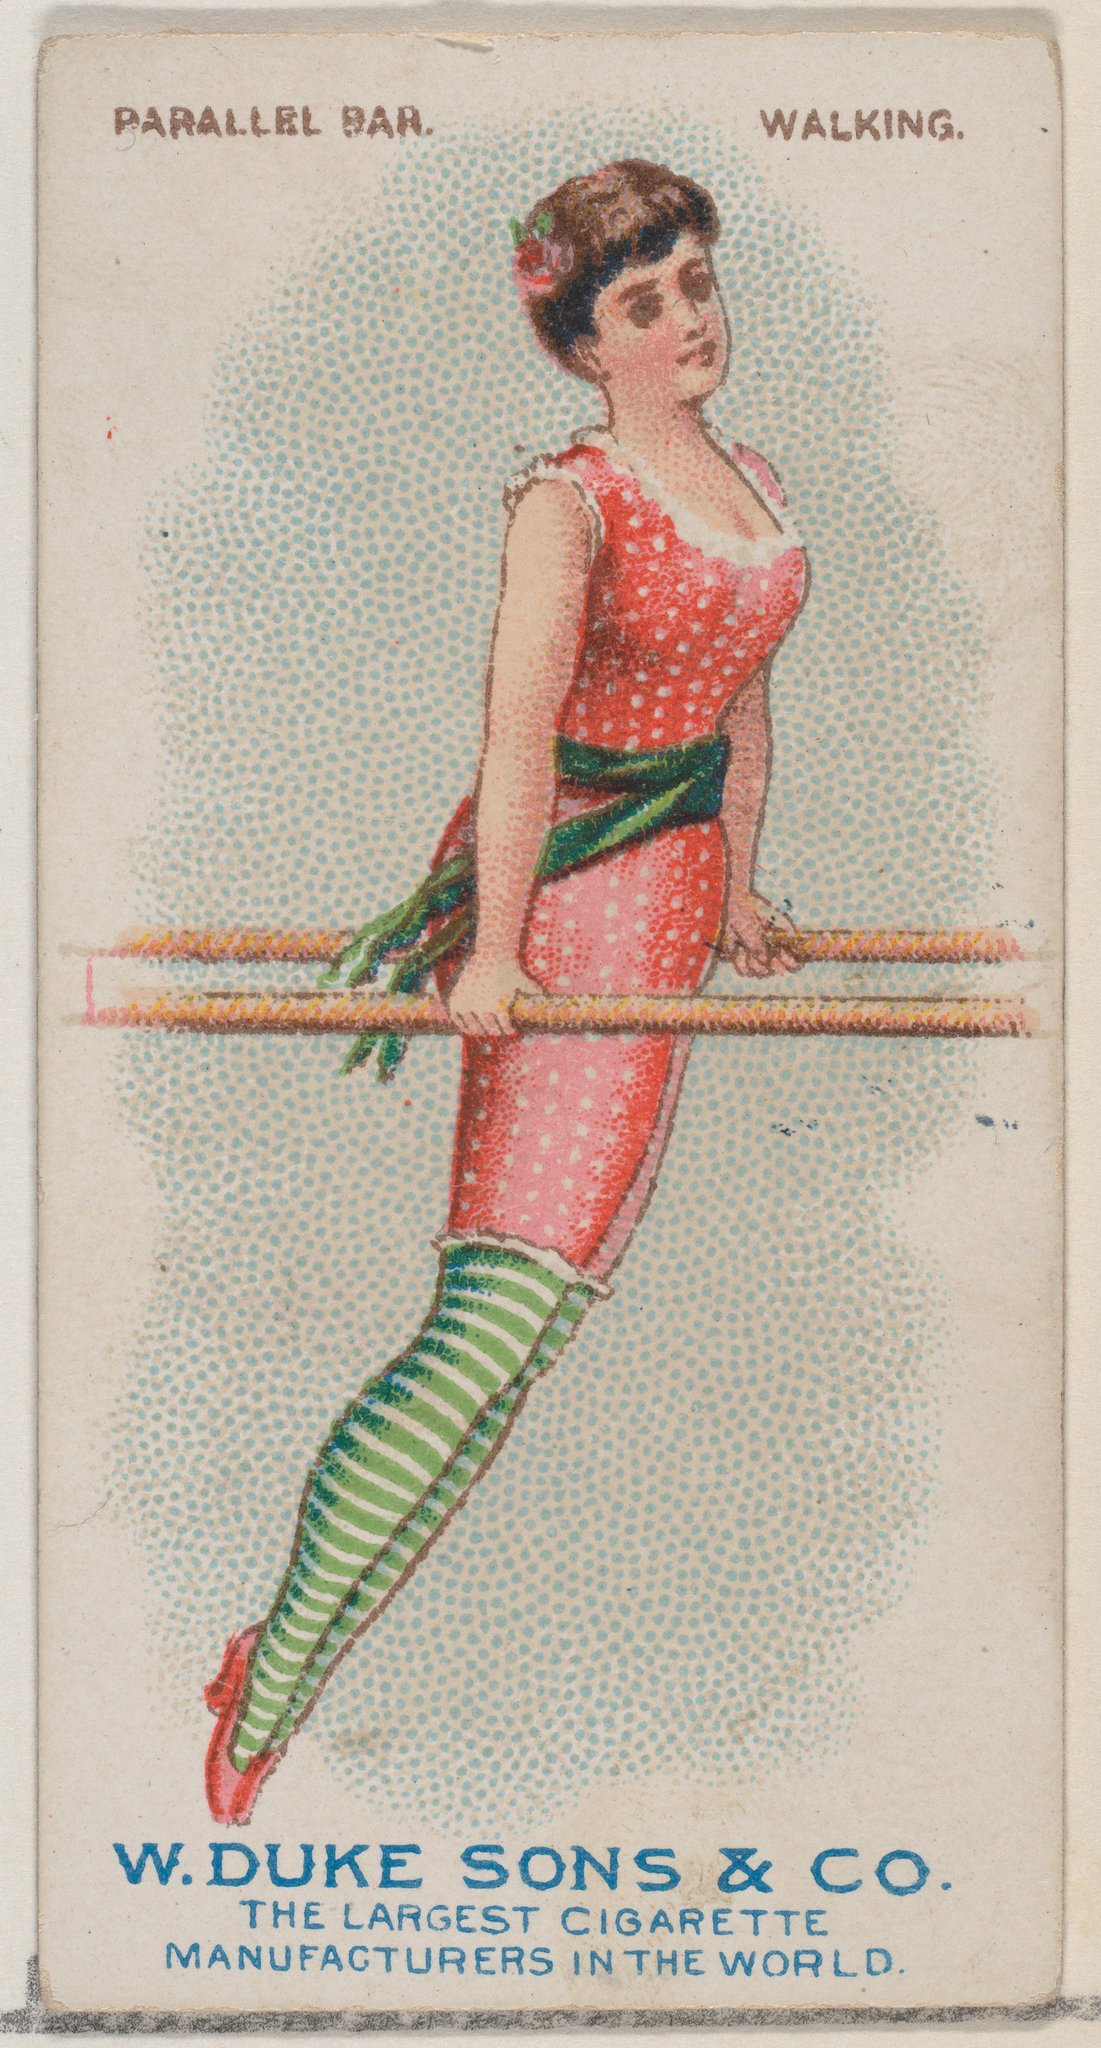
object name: print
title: Parallel Bar, Walking, from the Gymnastic Exercises series (N77) for Duke brand cigarettes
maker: w. duke, sons & co.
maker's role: publisher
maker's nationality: american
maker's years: 1870-1920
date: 1887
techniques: color lithograph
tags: women,sports,athletes